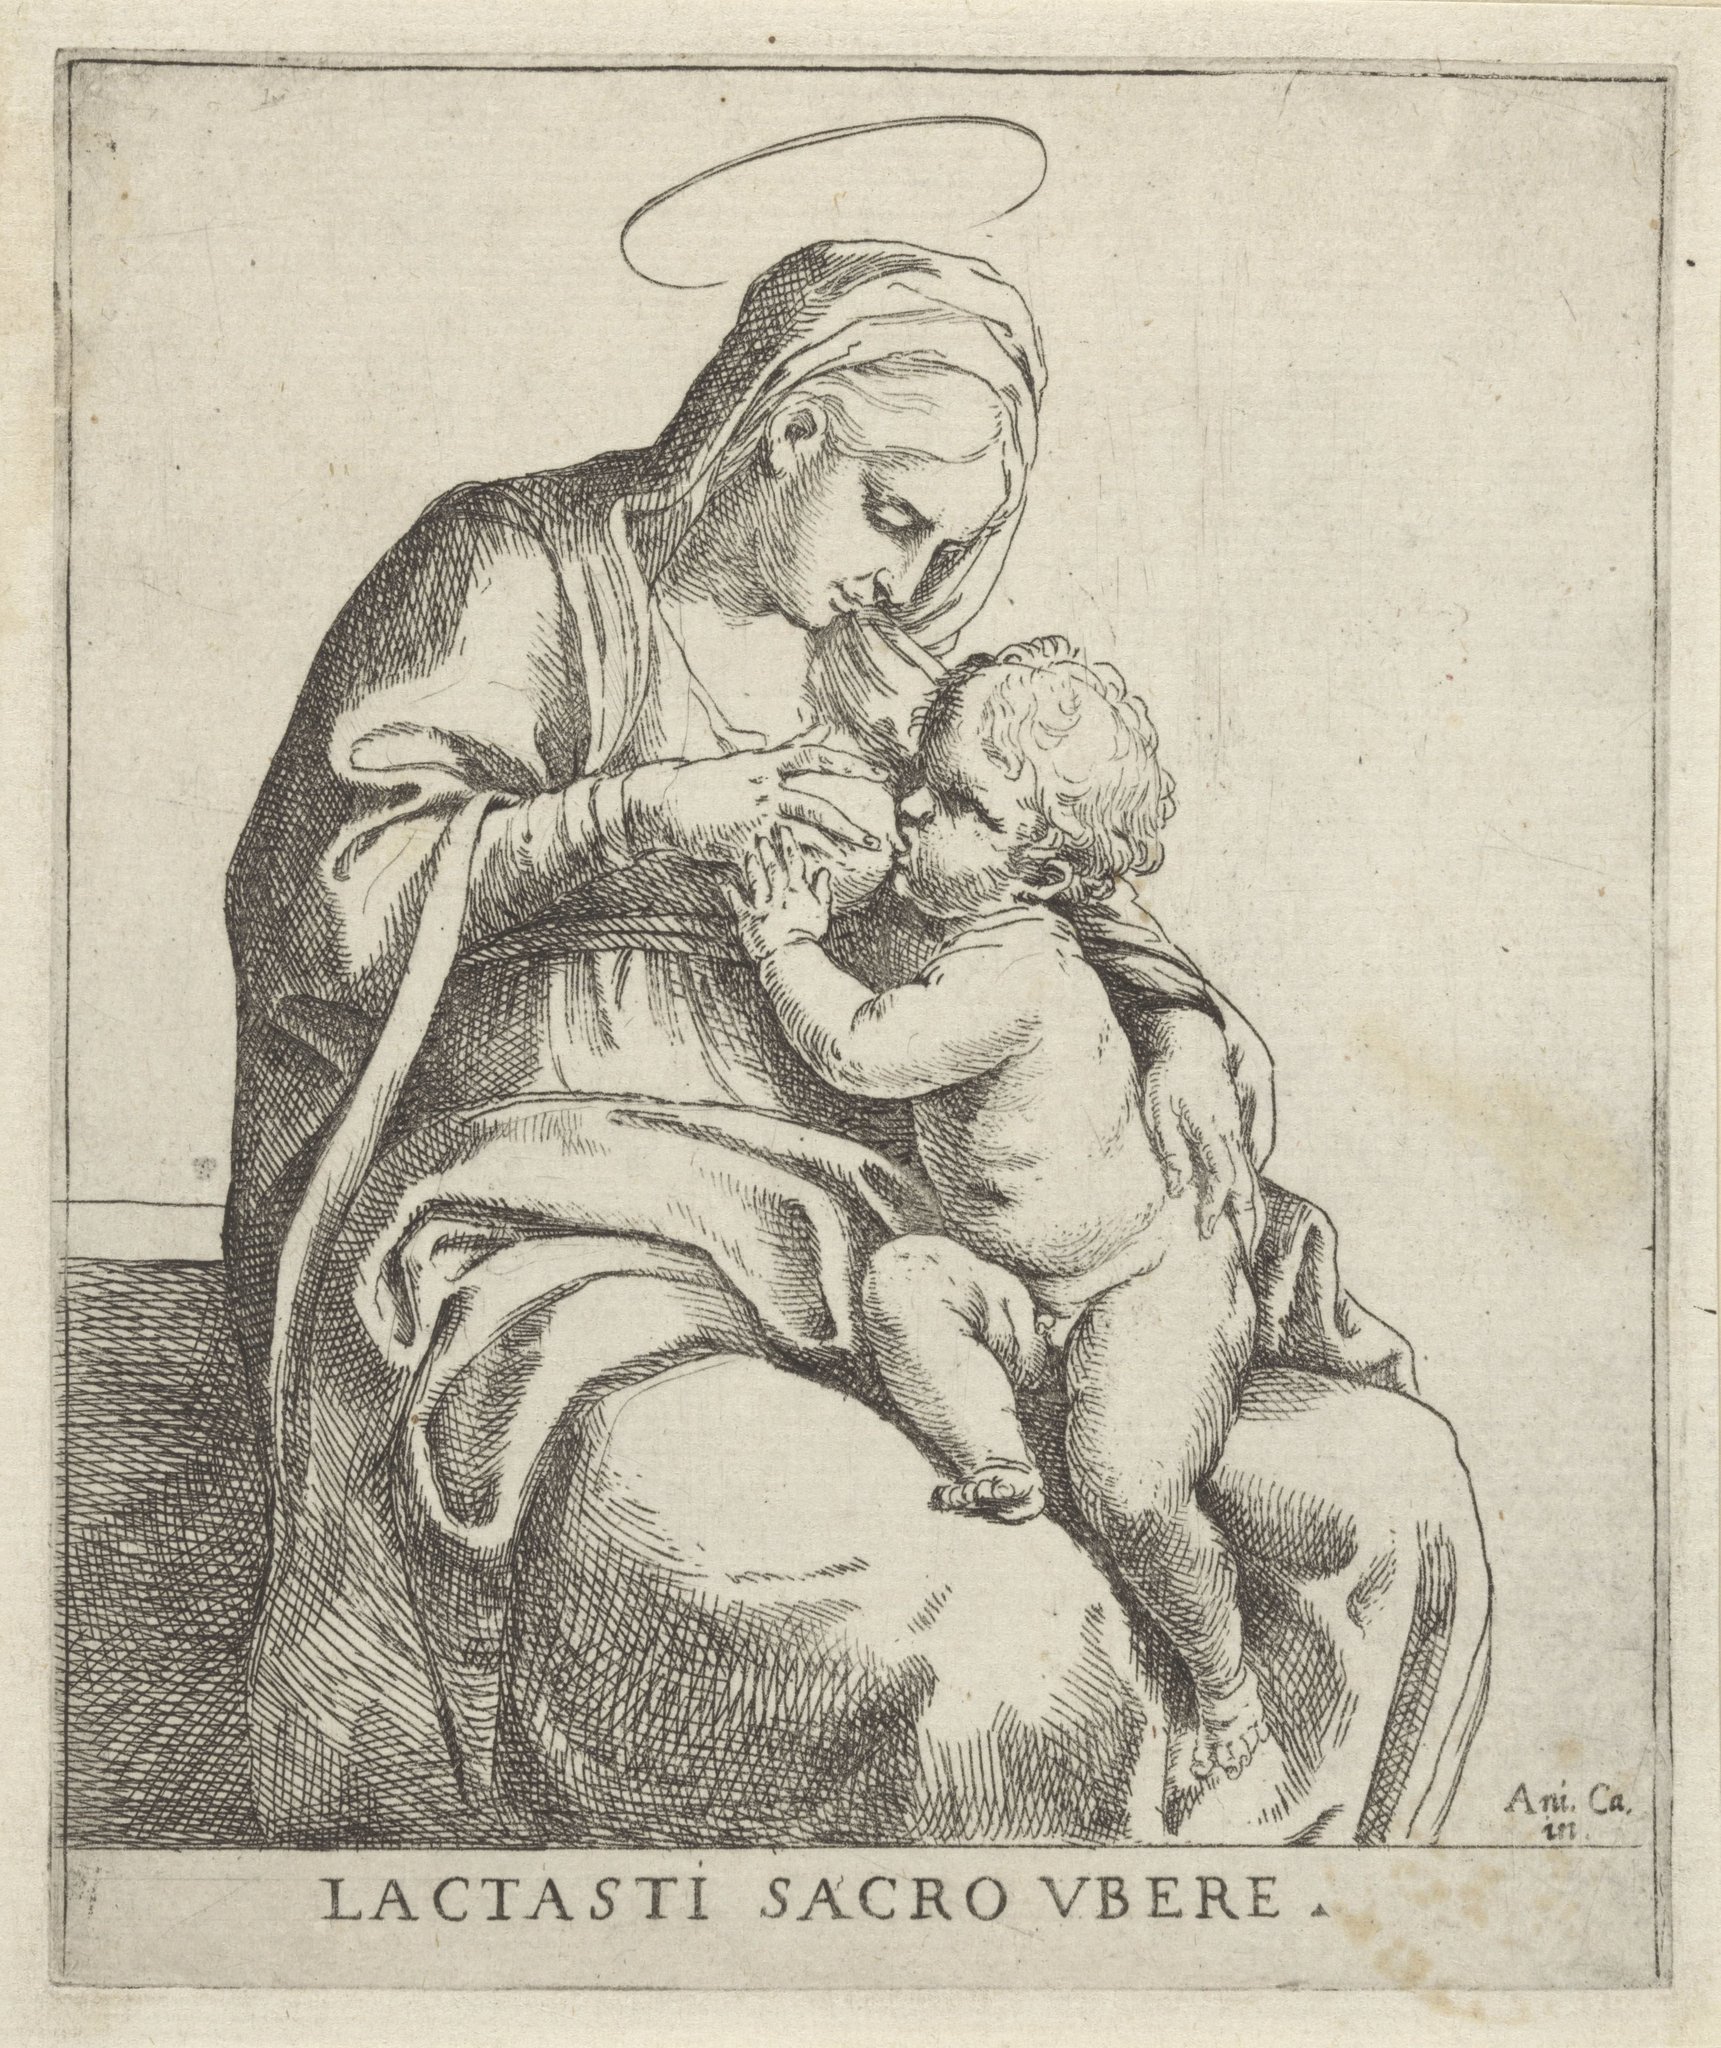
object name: print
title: Lactasti sacro ubere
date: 1570-1609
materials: paper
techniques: etching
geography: italy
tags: madonna: i.e. mary with the christ-child, christ-child suckling, or beginning to suckle, e.g. mary uncovering her breast ~ madonna-representations, 'madonna dell'umiltà' (usually mary suckling the christ-child while sitting on the ground)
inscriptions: collector's mark: Lugt 240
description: Maria zit met het Christuskind op schoot en geeft hem de borst.